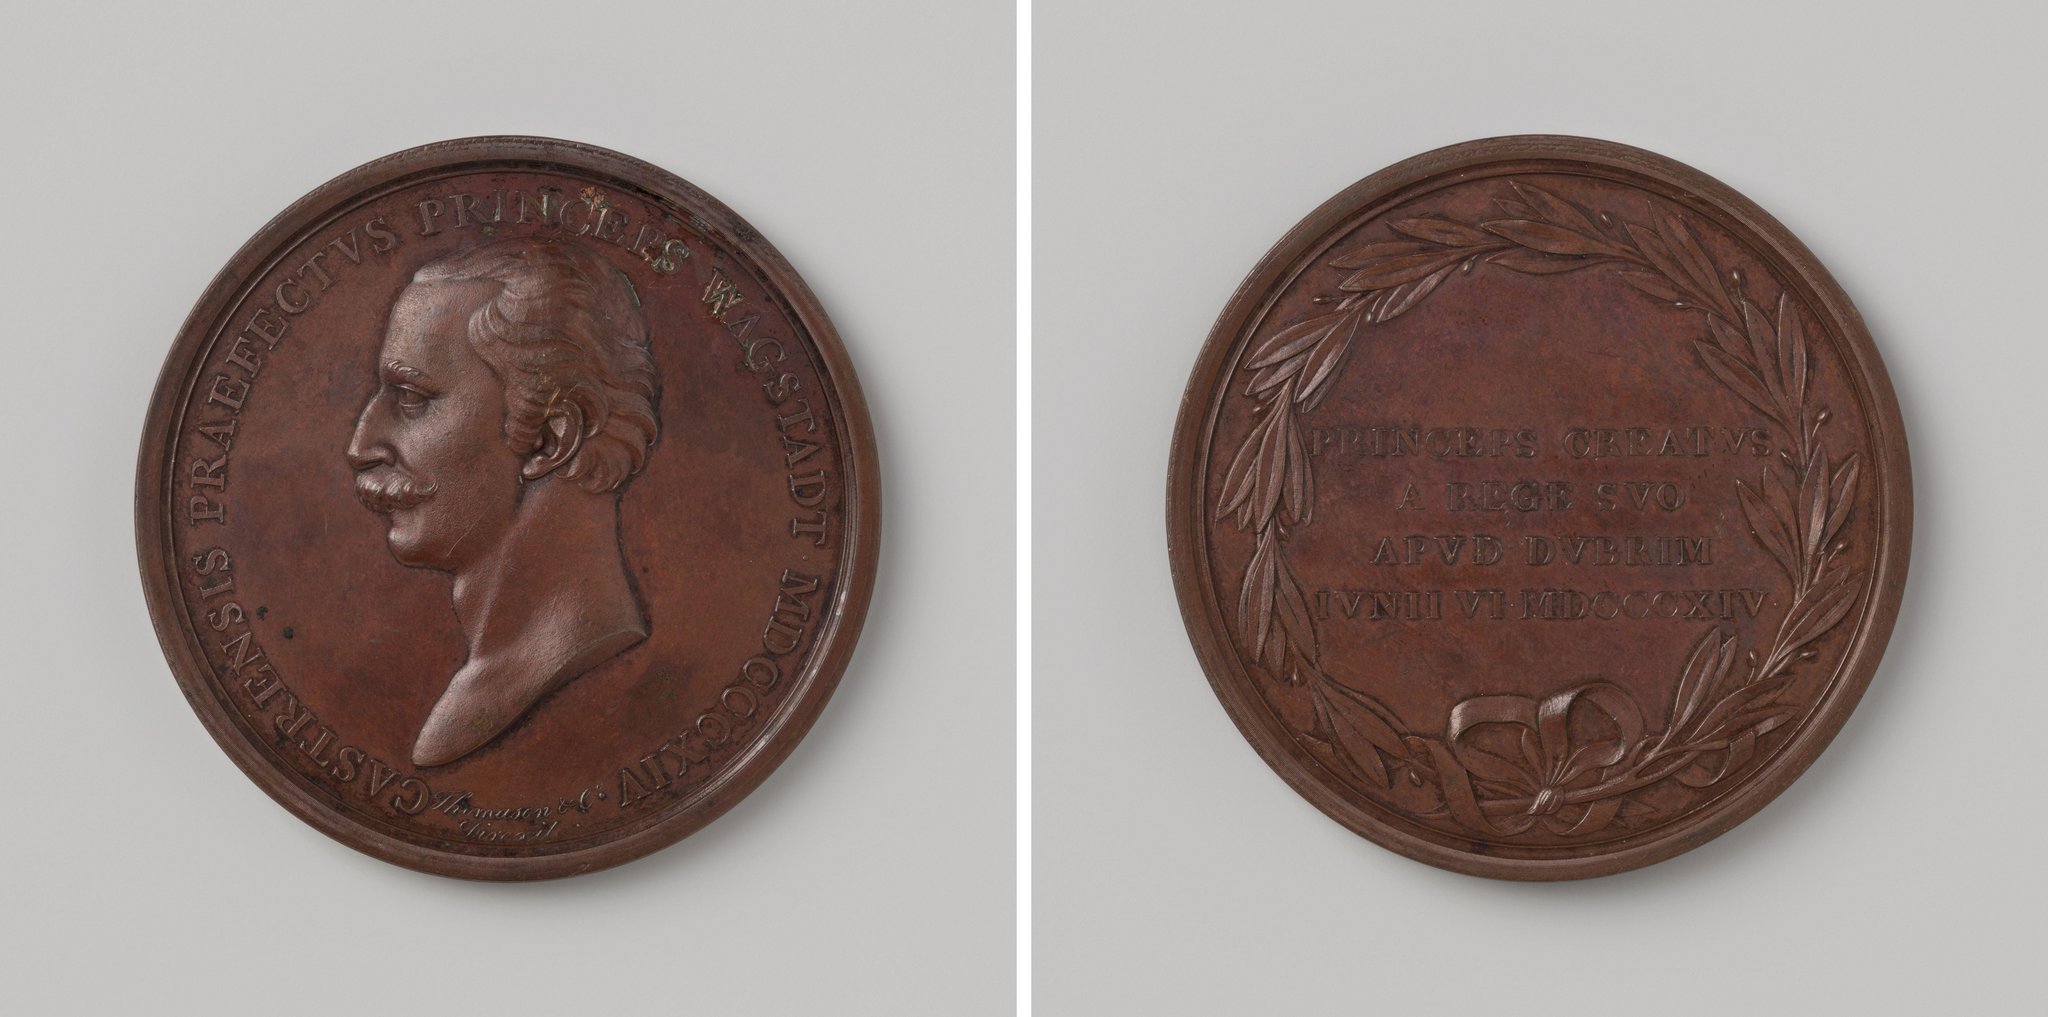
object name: history medal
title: Gebhard Leberecht von Blucher door Frederik Willem III, koning van Pruisen verheven tot vorst van Wahlstatt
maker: edward thomason (sir)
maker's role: medailleur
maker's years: 1769-1849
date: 1814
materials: bronze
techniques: striking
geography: birmingham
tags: generaal, gebhard leberecht von blücher von wahlstatt, napoleontische oorlogen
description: Bronzen penning. Voorzijde: borststuk man binnen omschrift. Keerzijde: opschrift binnen lauwerkrans